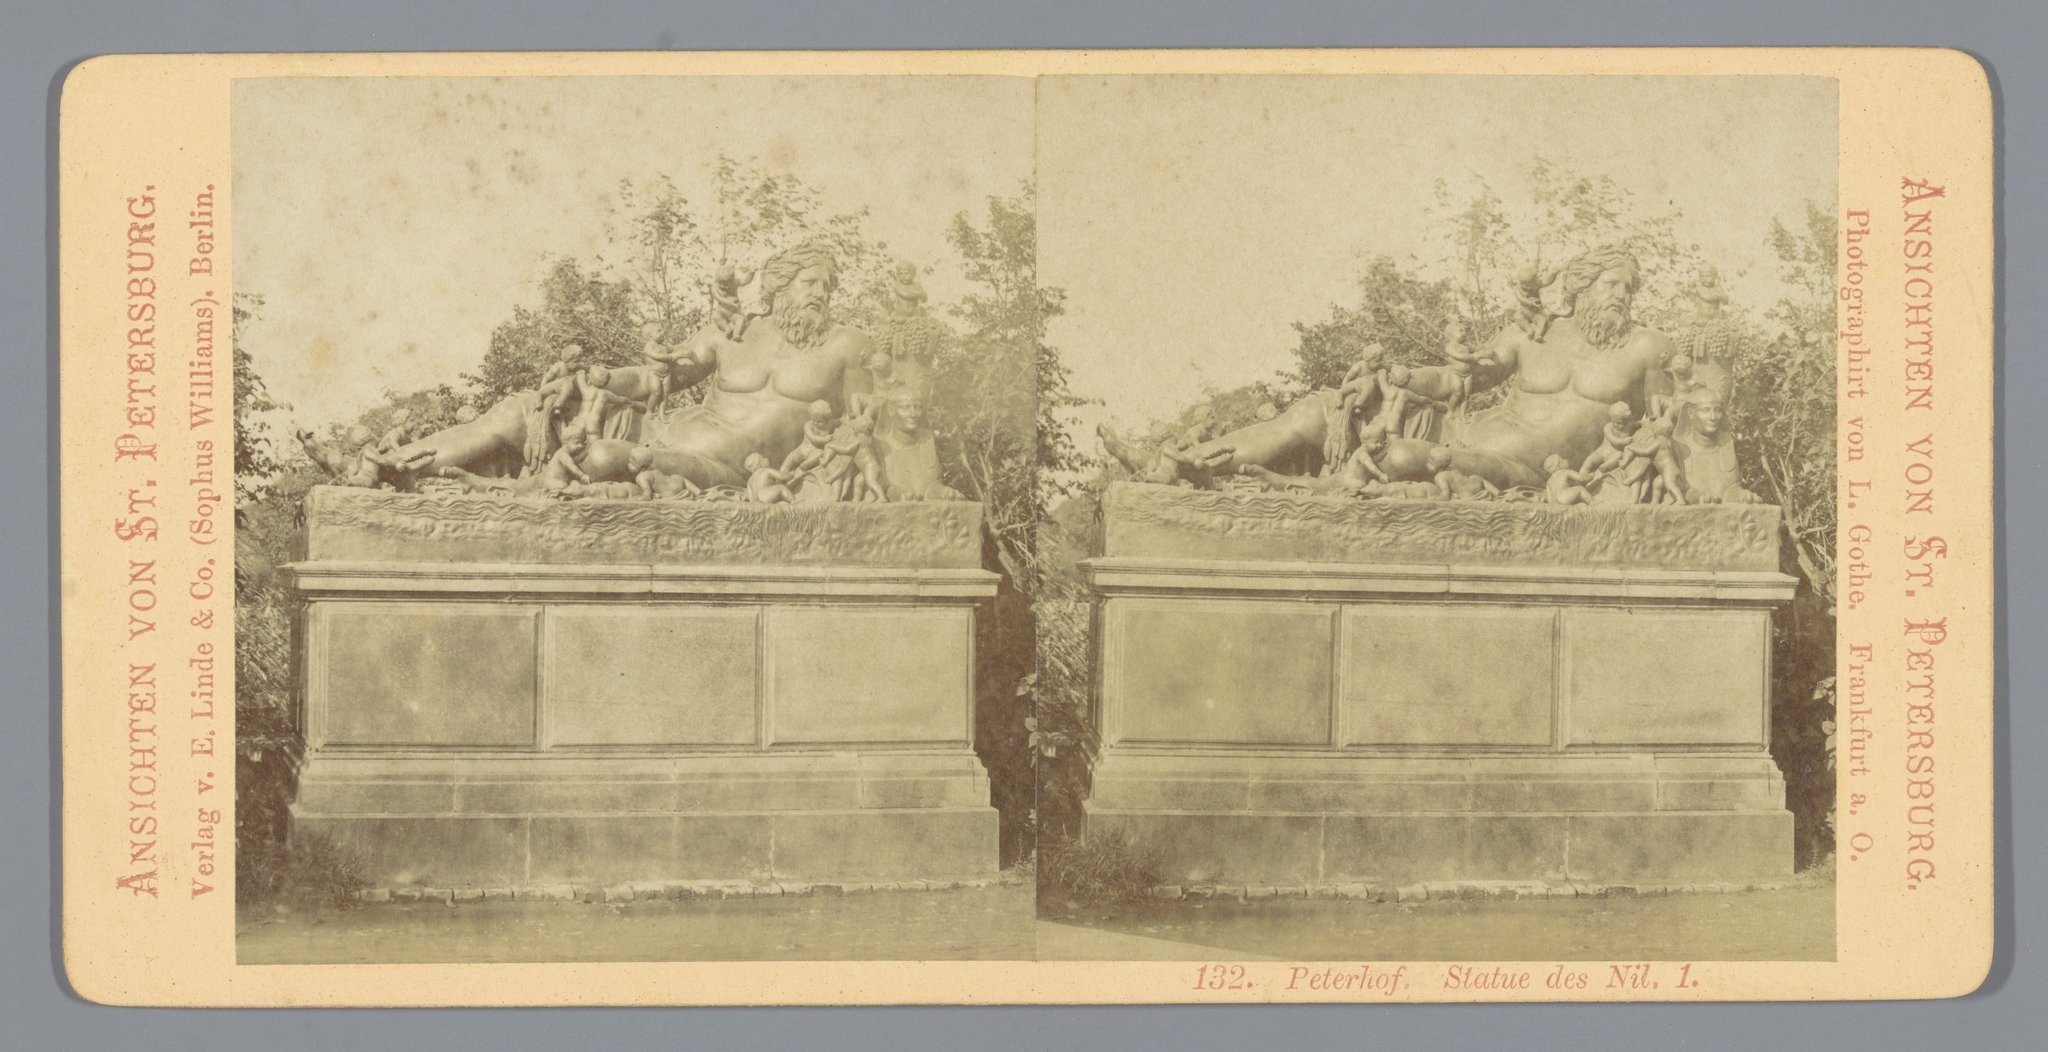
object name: stereograph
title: Sculptuur van de personificatie van de Nijl in Peterhof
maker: louis gothe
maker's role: fotograaf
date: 1850-1880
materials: cardboard, photographic support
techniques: albumen print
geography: berlin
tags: piece of sculpture, reproduction of a piece of sculpture, personification of river nile; 'nilo' (ripa)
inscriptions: inscription: ‘Ansichten von St. Petersburg.’, number: ‘132.’